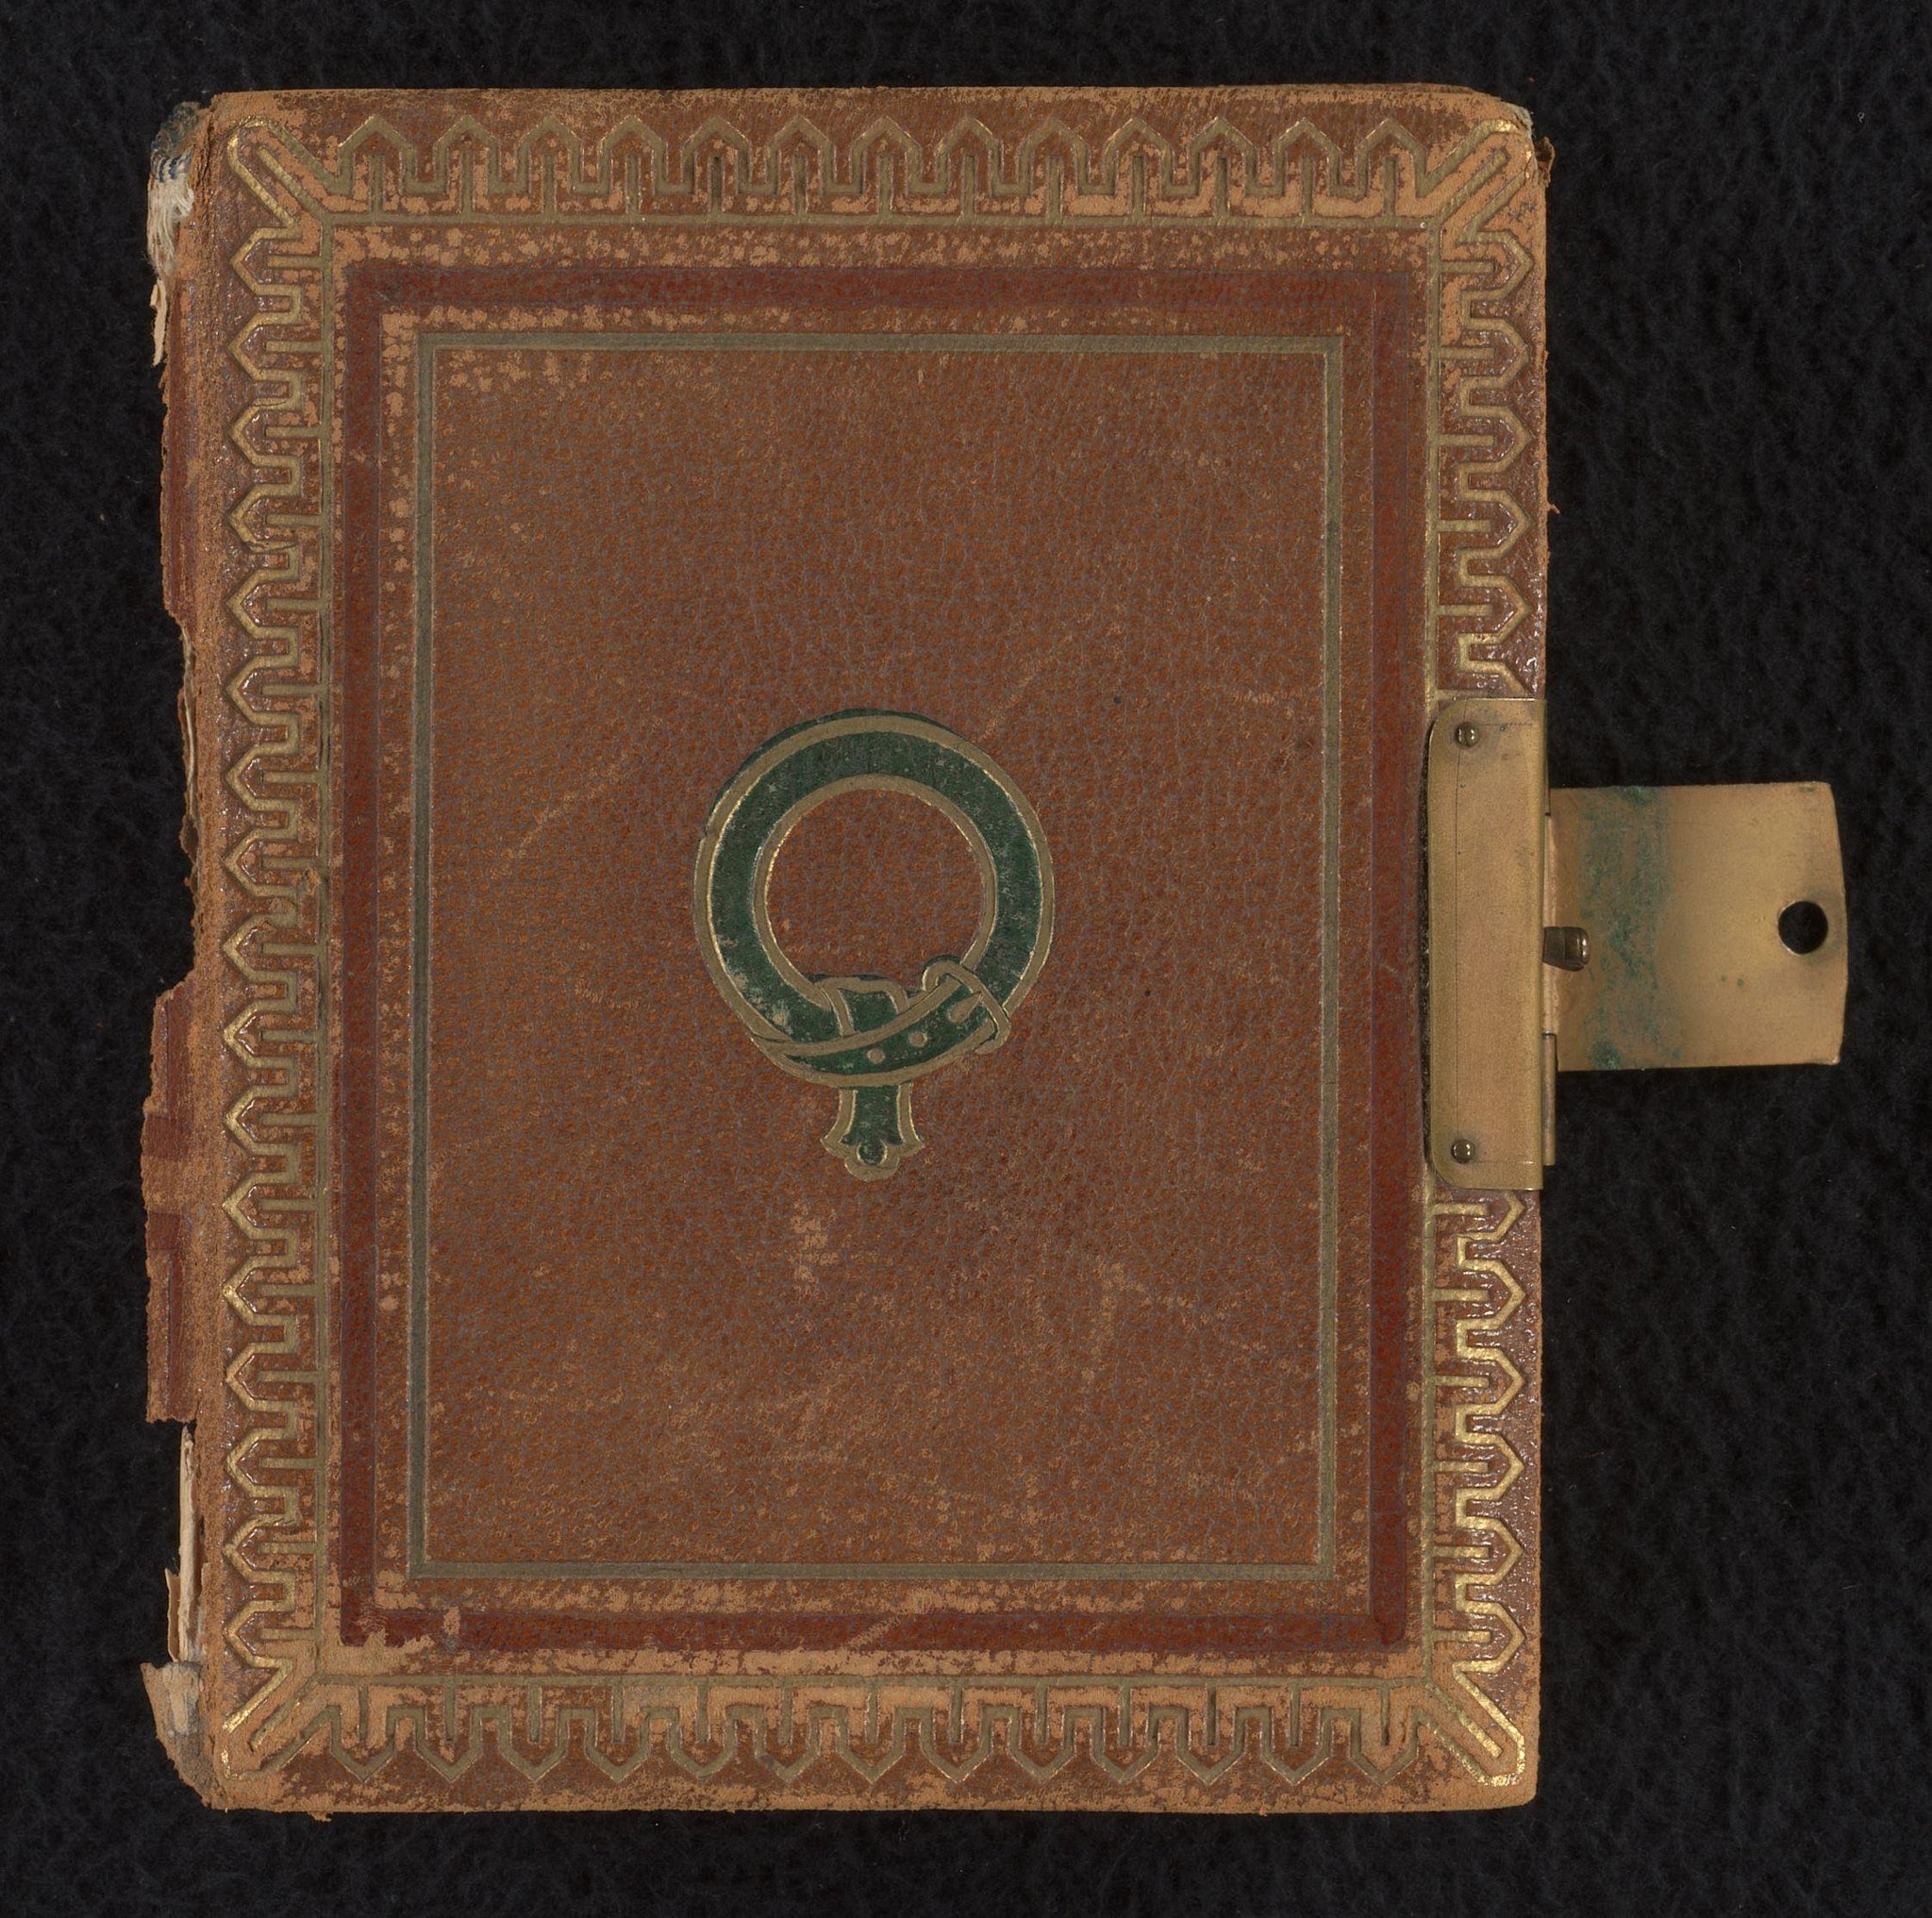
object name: photograph album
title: Album met cartes-de-visite van de familie Jonker-Nije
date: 1860-1920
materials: cardboard, leather, paper, photographic support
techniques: albumen print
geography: netherlands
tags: adolescent, young woman, maiden, historical persons - bb - woman, historical persons, youth, adolescent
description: Fotoalbum met 13 bladen met in totaal 28 foto's. Het album bevat portretten van de familie Jonker-Nije en een aantal kennissen. De foto's zijn onder andere vervaardigd door Albert Greiner, Max Büttinghausen en Johannes Leonardus van der Heijden.